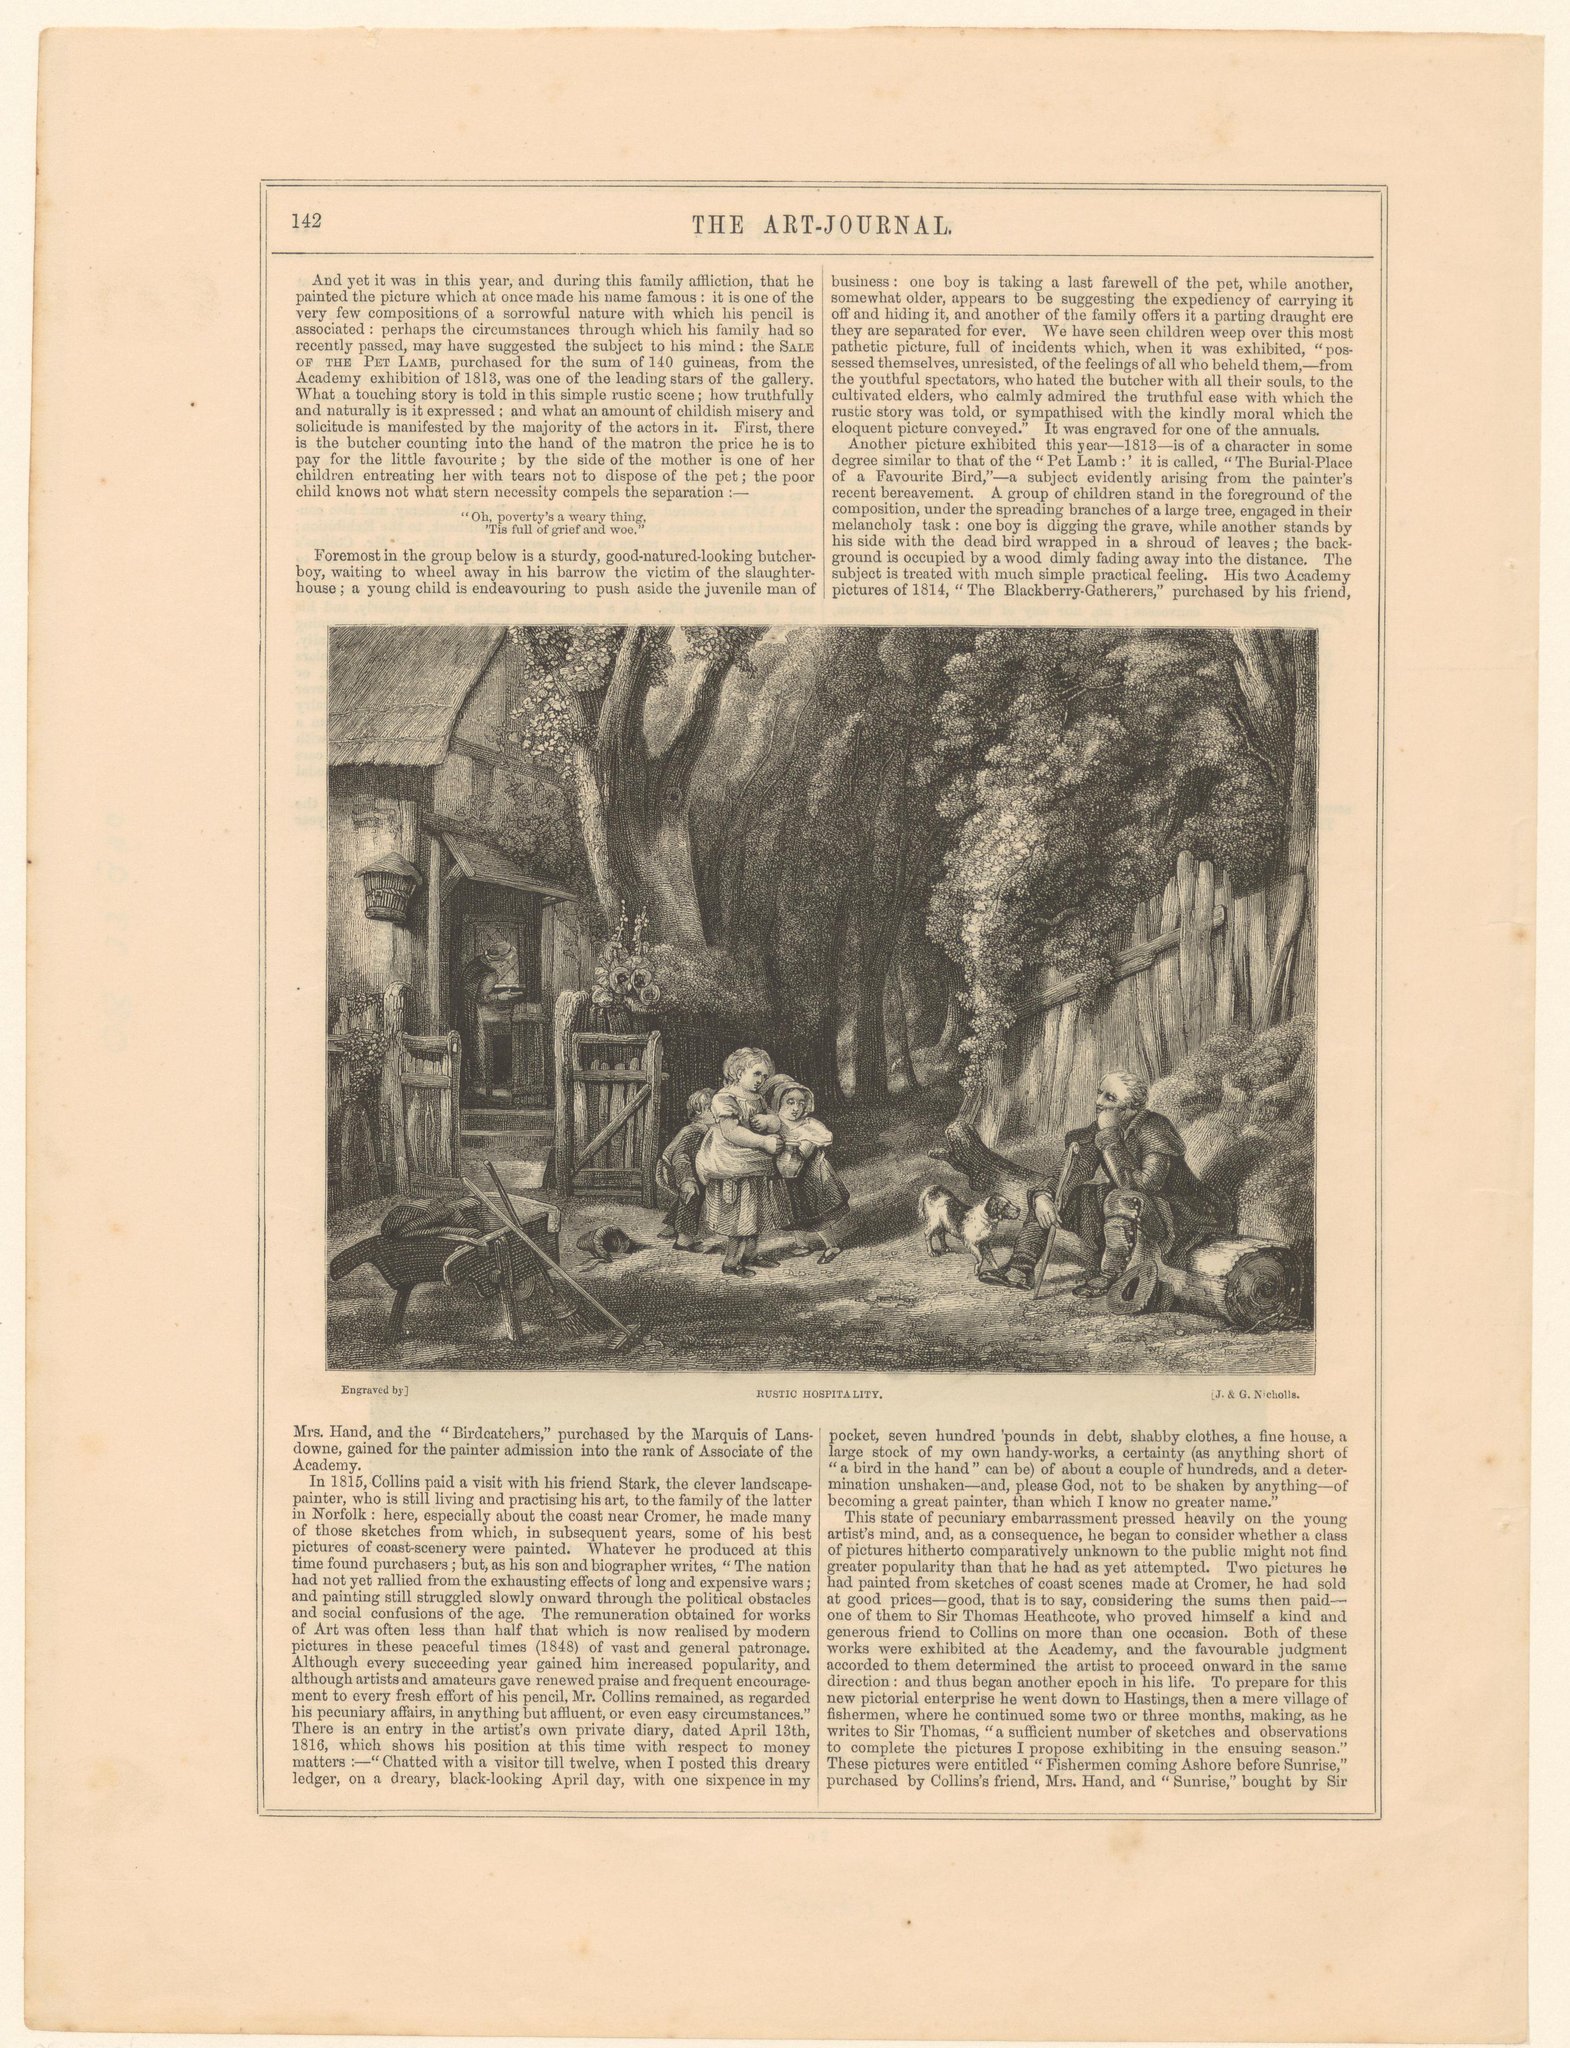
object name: print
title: The fisherman's departure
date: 1855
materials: paper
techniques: letterpress printing, engraving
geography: london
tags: family life at home, waving farewell ~ departure on a journey, fisherman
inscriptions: collector's mark: Lugt 2228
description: Prent uit: The Art Journal (1855), 1855, p. 141.